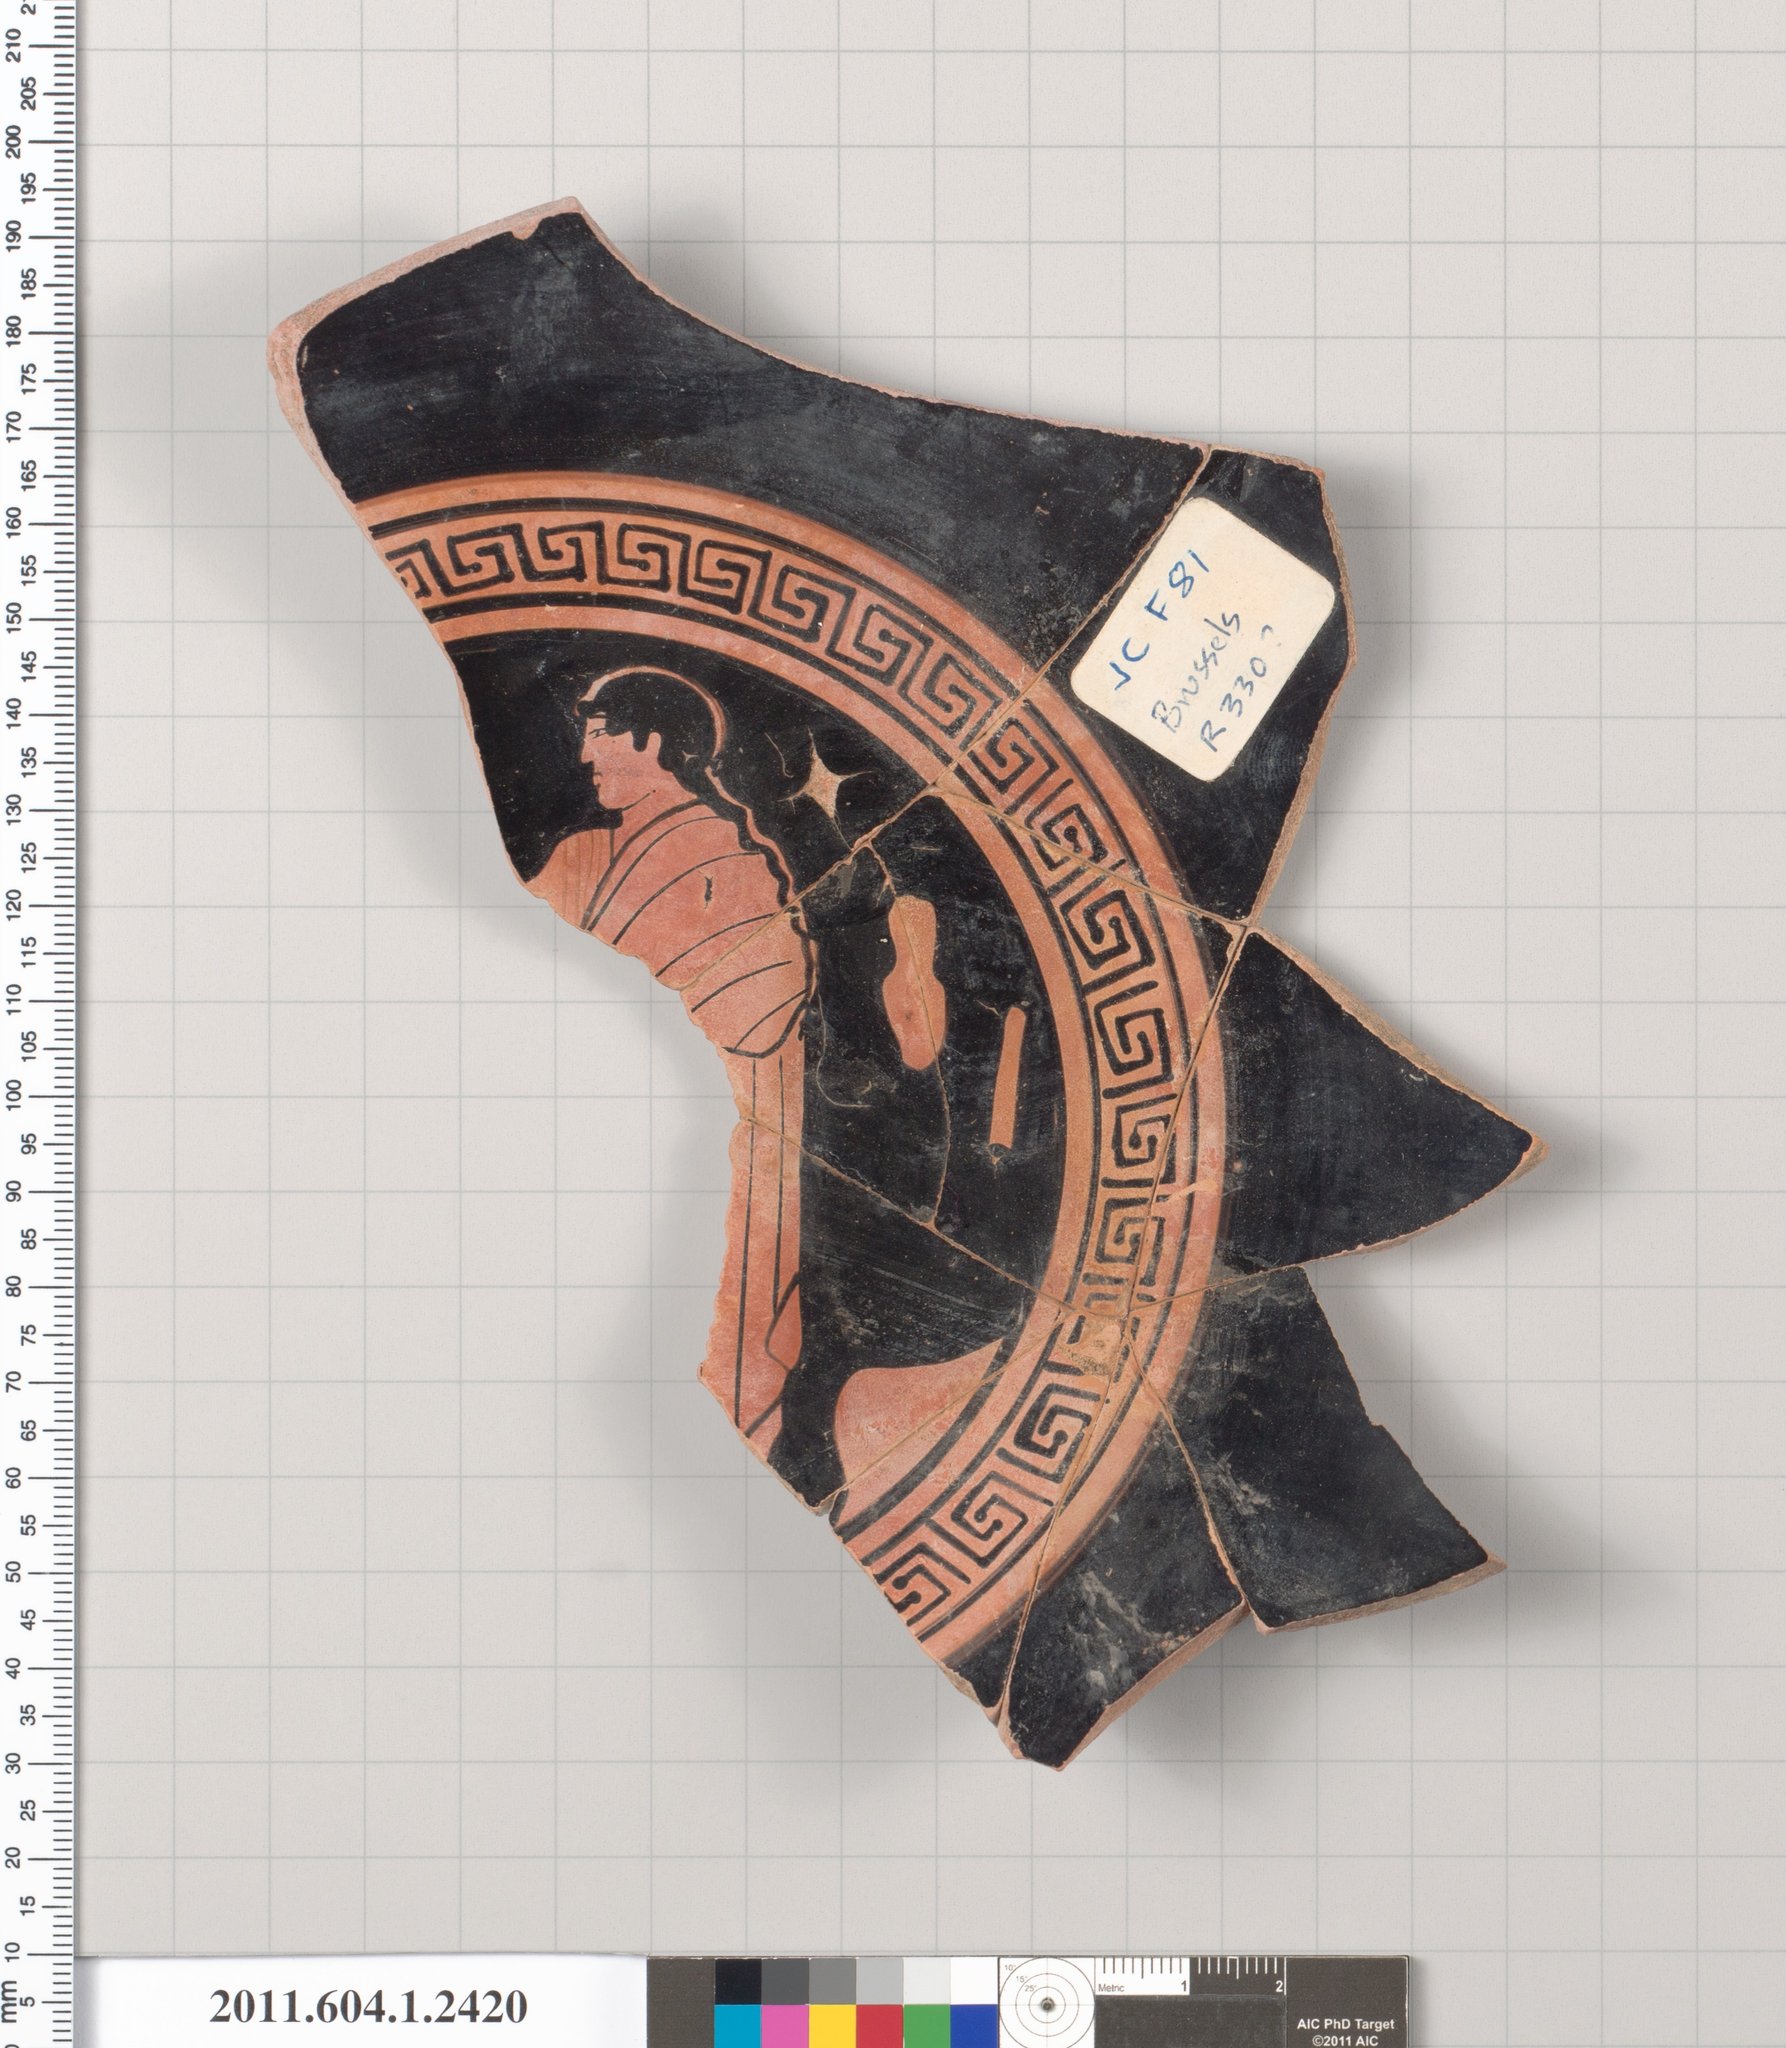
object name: kylix fragment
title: Terracotta fragment of a kylix (drinking cup)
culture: greek, attic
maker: painter of brussels r 330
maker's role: artist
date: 475-451 BCE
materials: terracotta